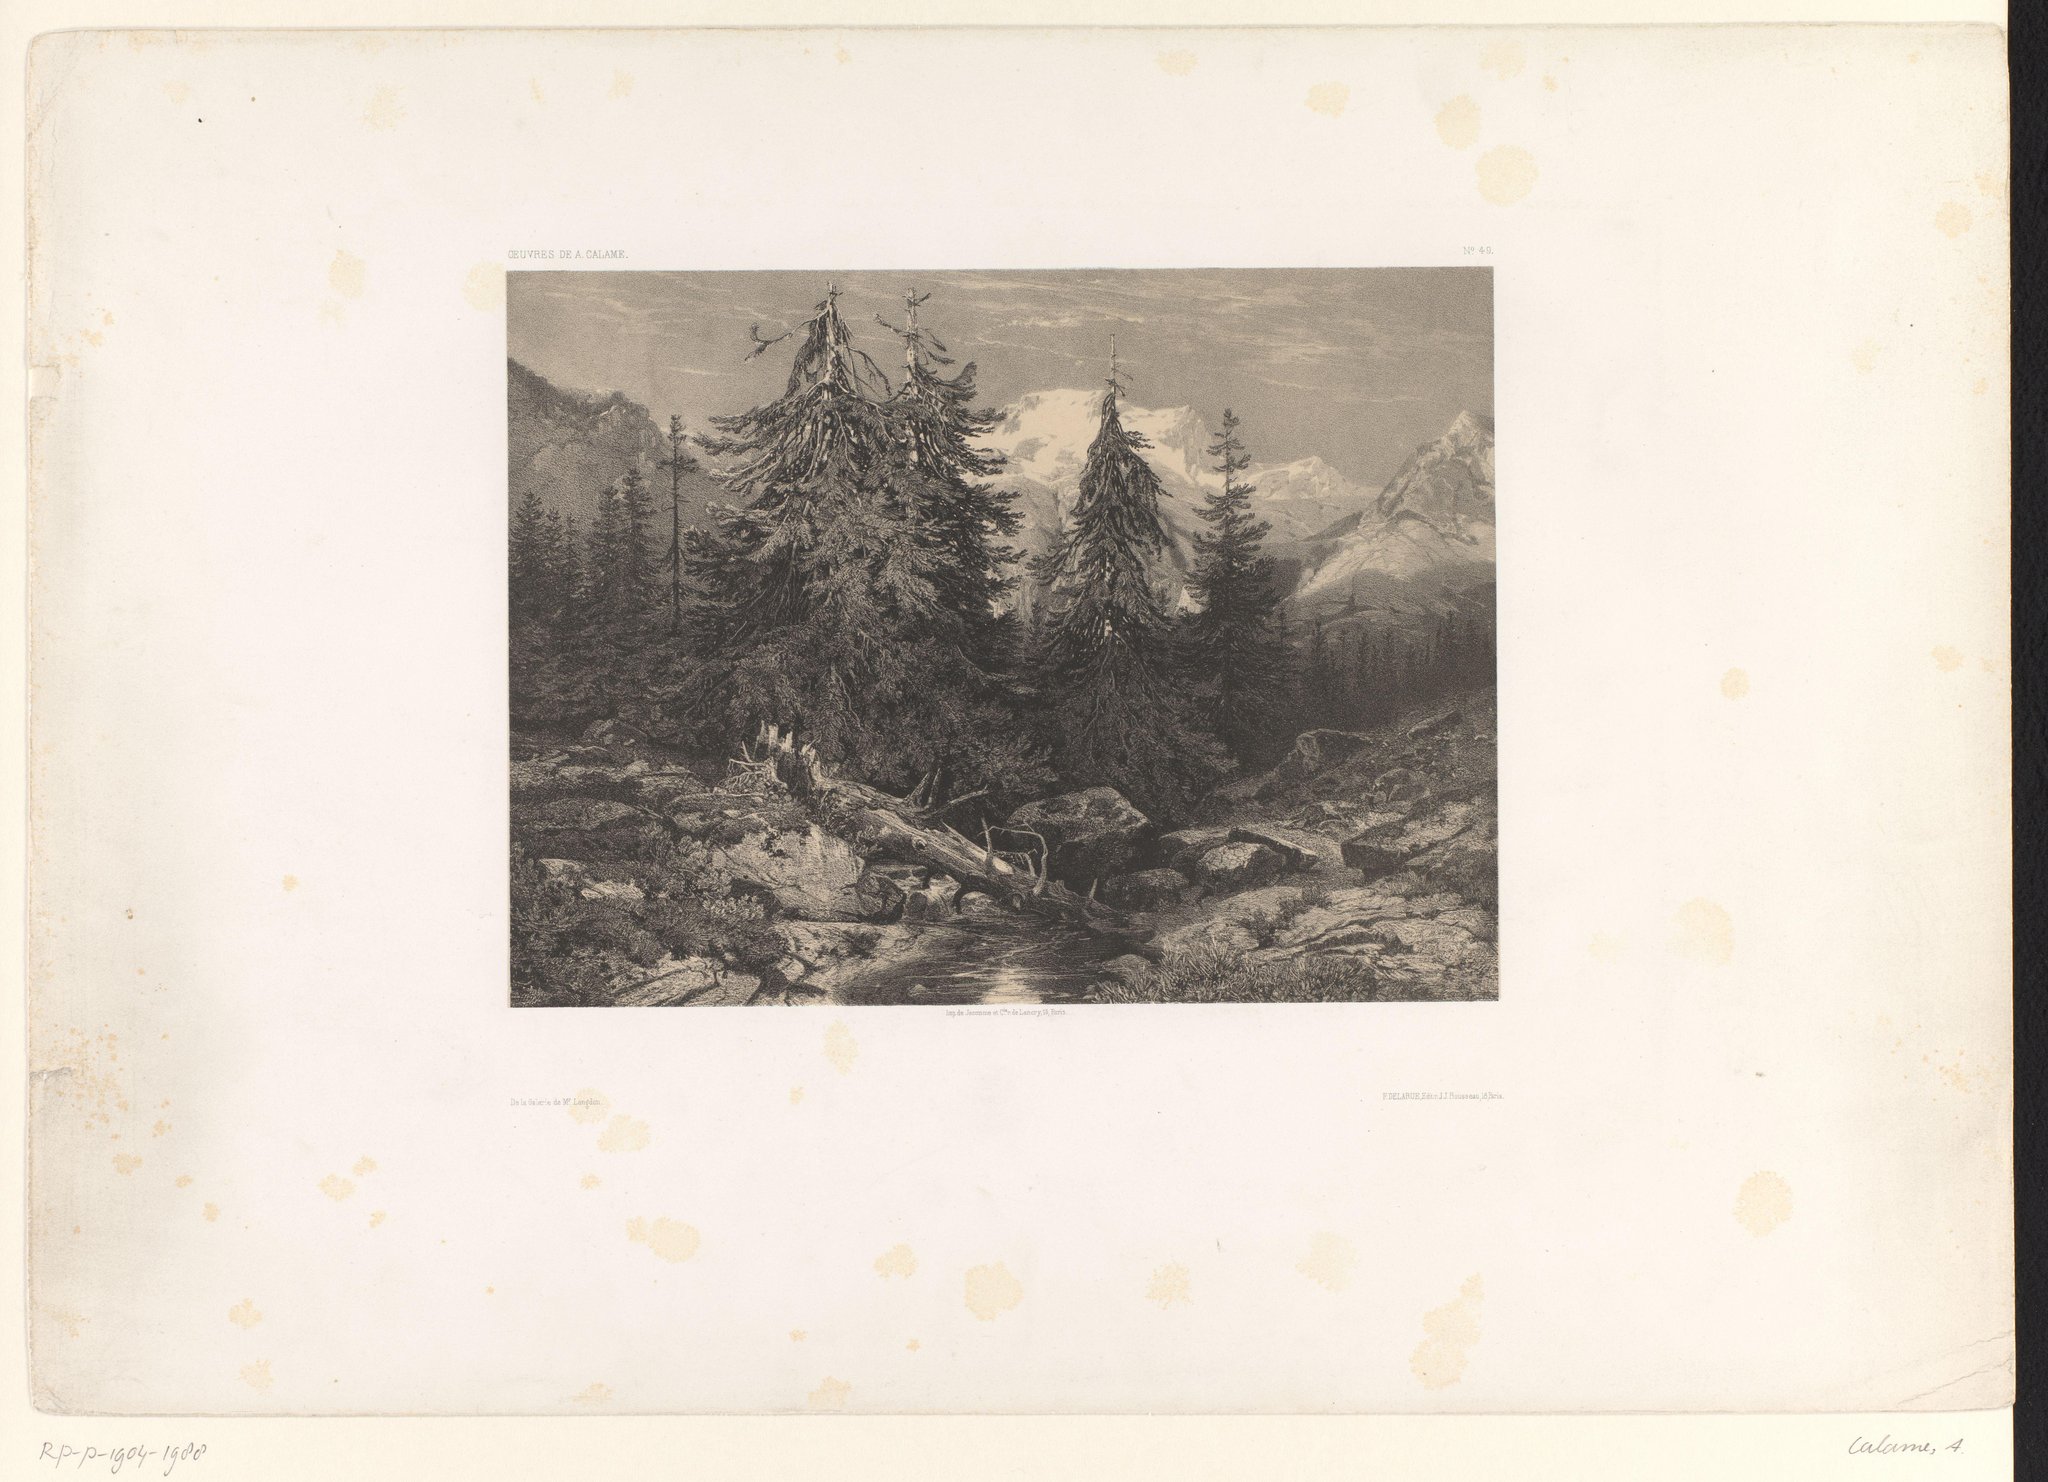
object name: print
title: Berglandschap met naaldbomen, beek en omgevallen boom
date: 1852-1855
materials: paper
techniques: lithograph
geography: paris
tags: trees (+ stem, trunk), brook, mountain-range, snow peaks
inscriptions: collector's mark: Lugt 2228a